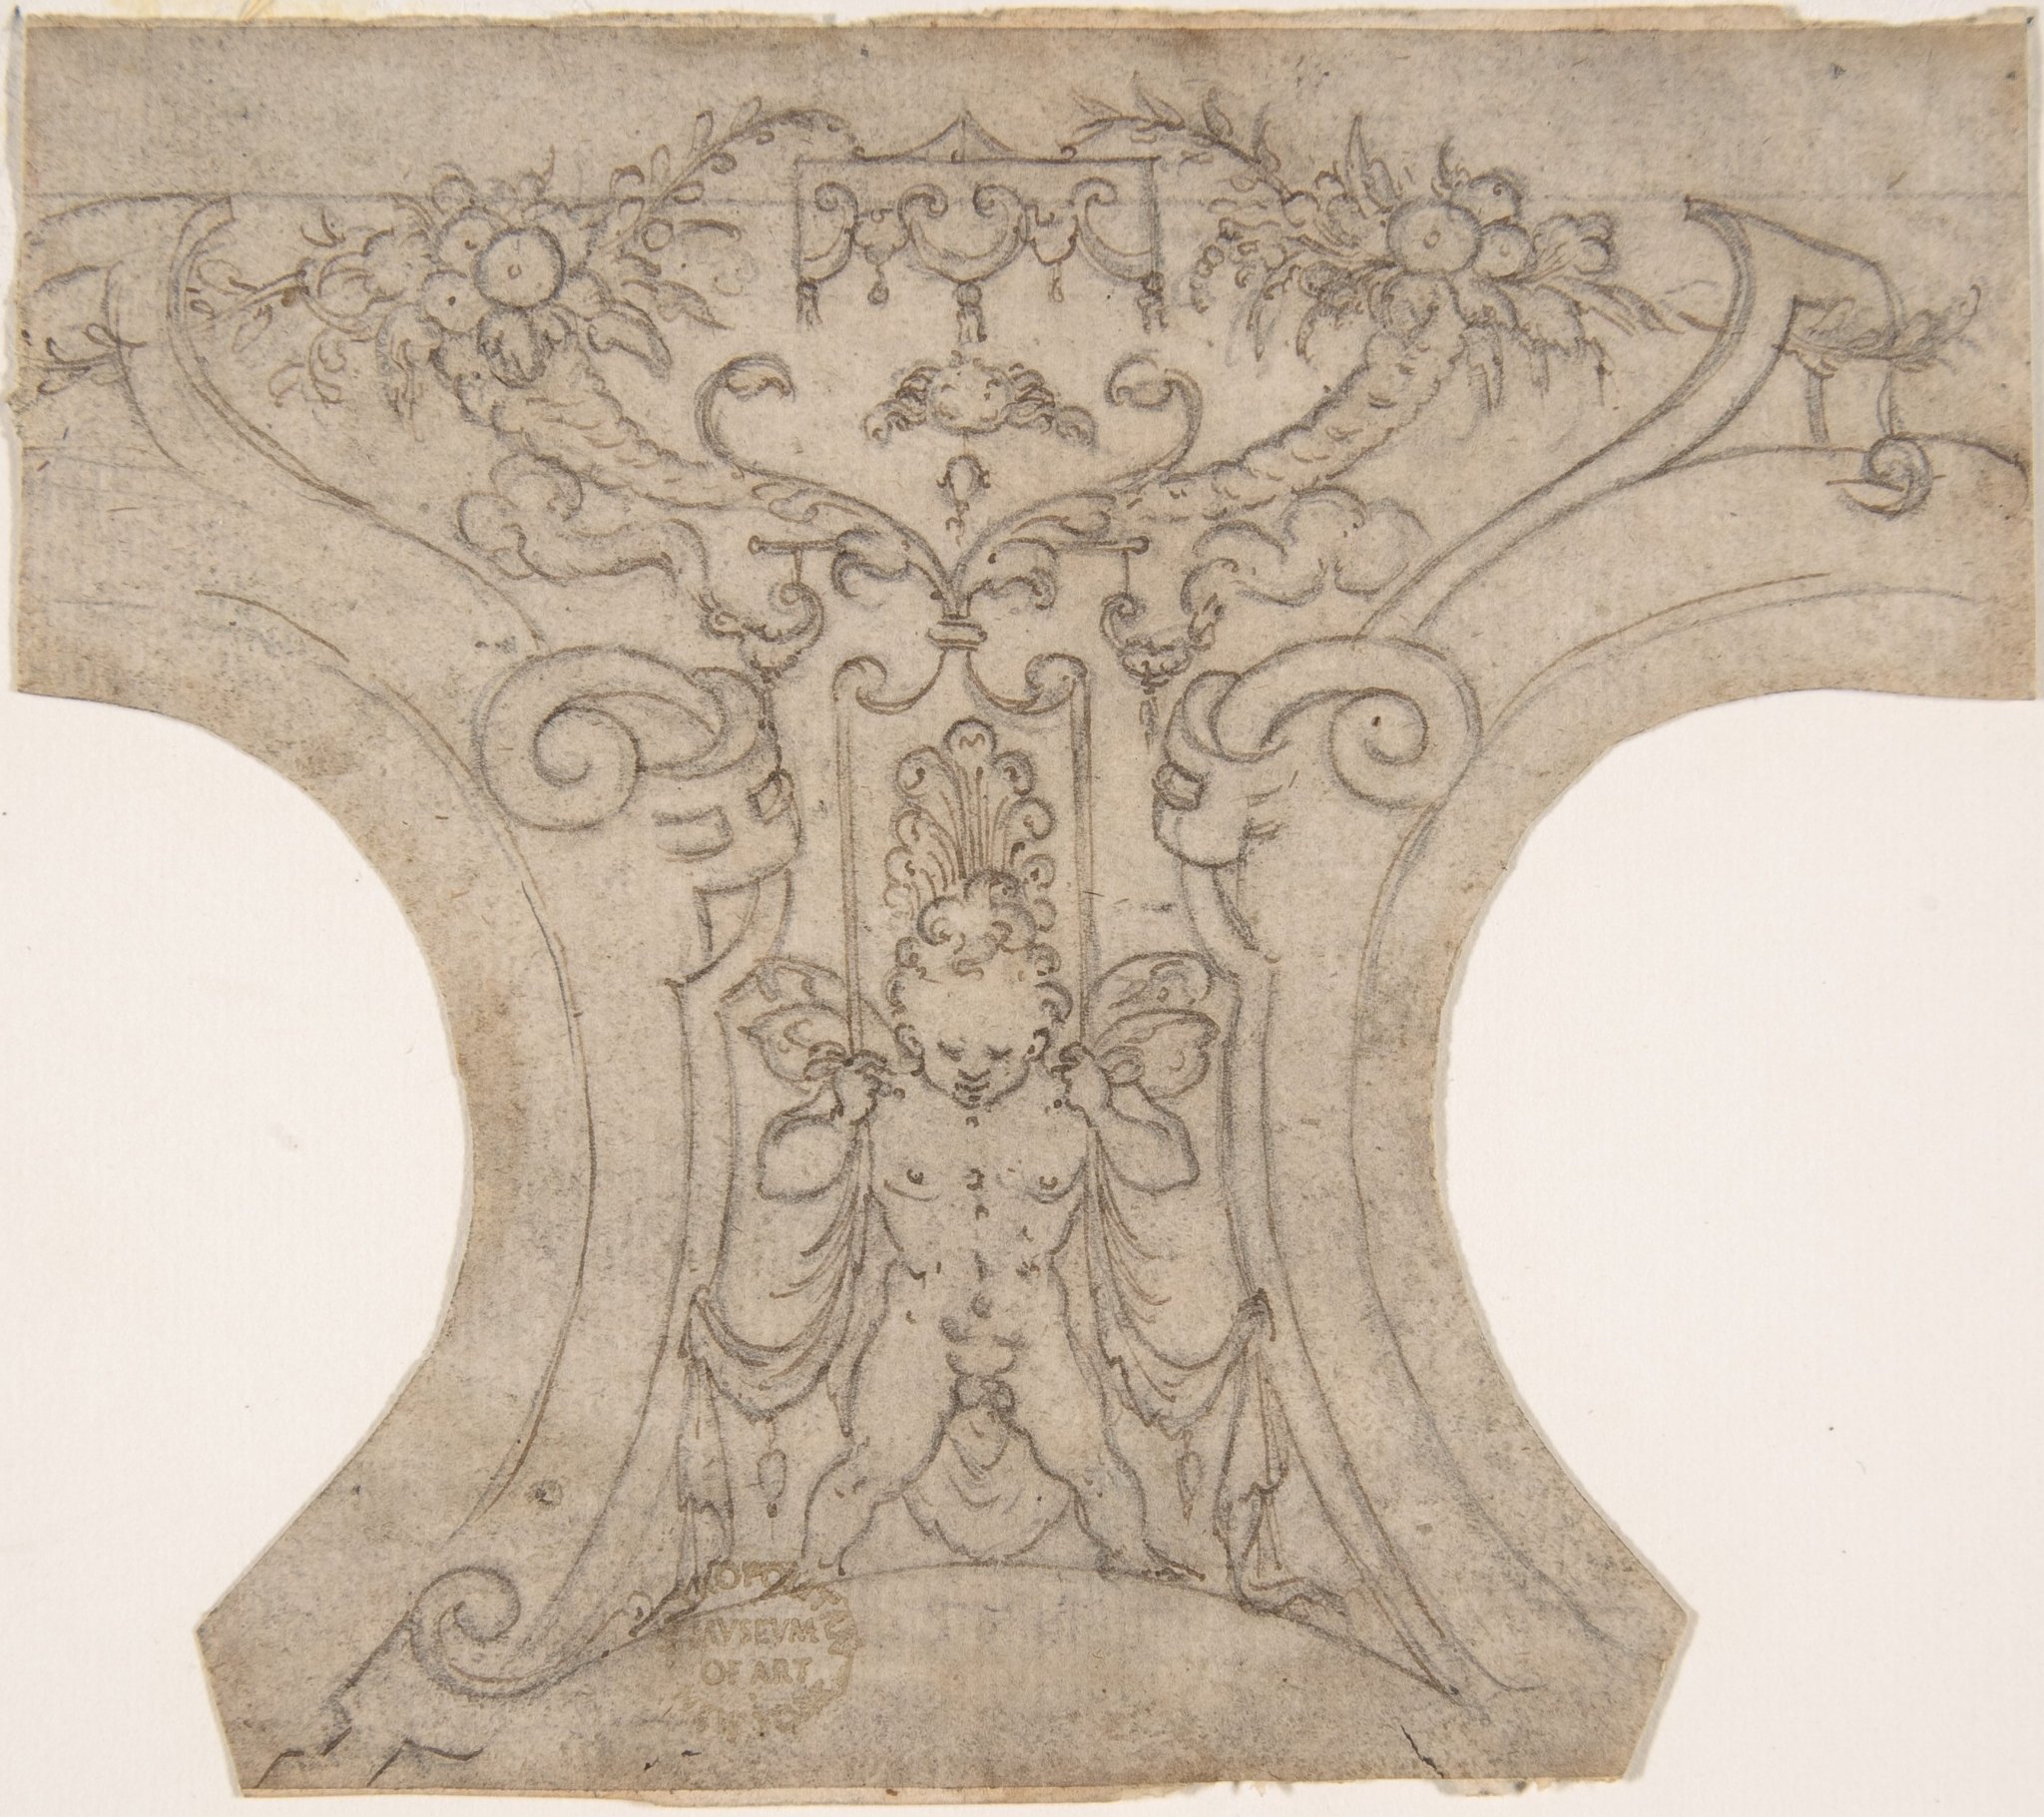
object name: drawing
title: Decoration for a Spandrel in a Cove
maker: anonymous, italian, 16th century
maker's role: artist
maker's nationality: italian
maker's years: 1550-1600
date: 1501-1600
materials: chalk, ink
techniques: pen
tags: ornament